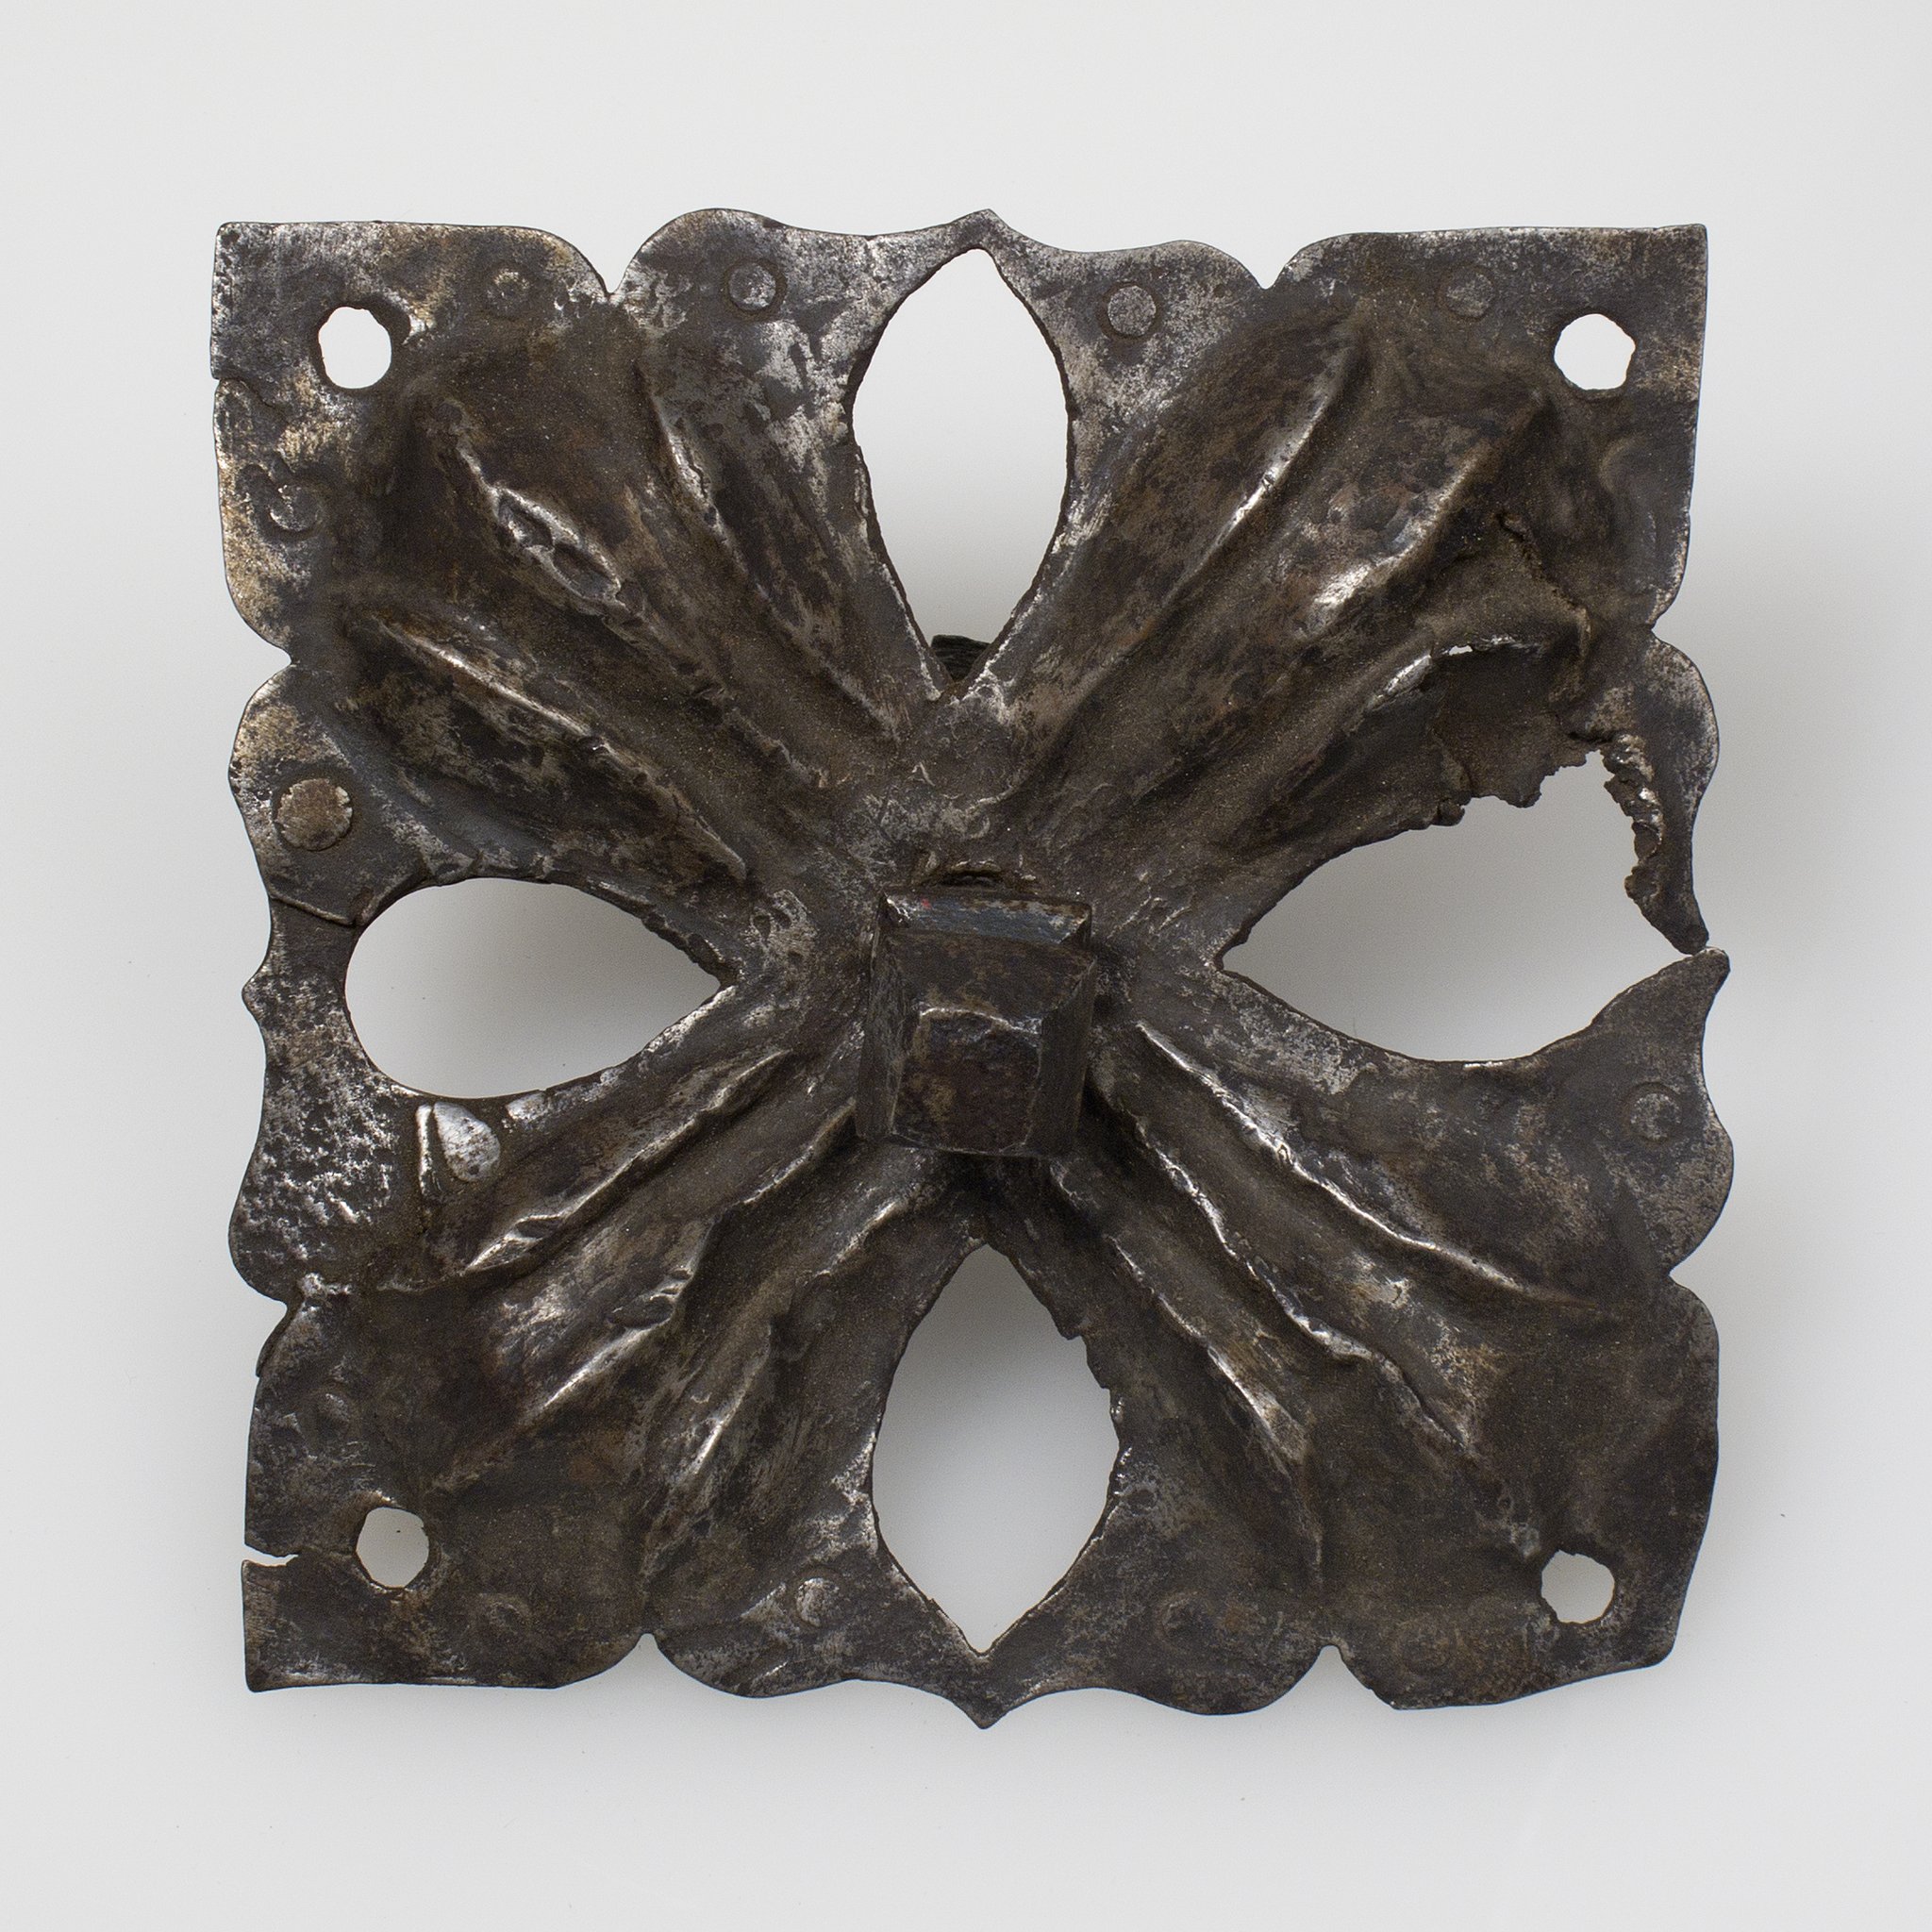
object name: plate and nail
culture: european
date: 1401-1600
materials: iron